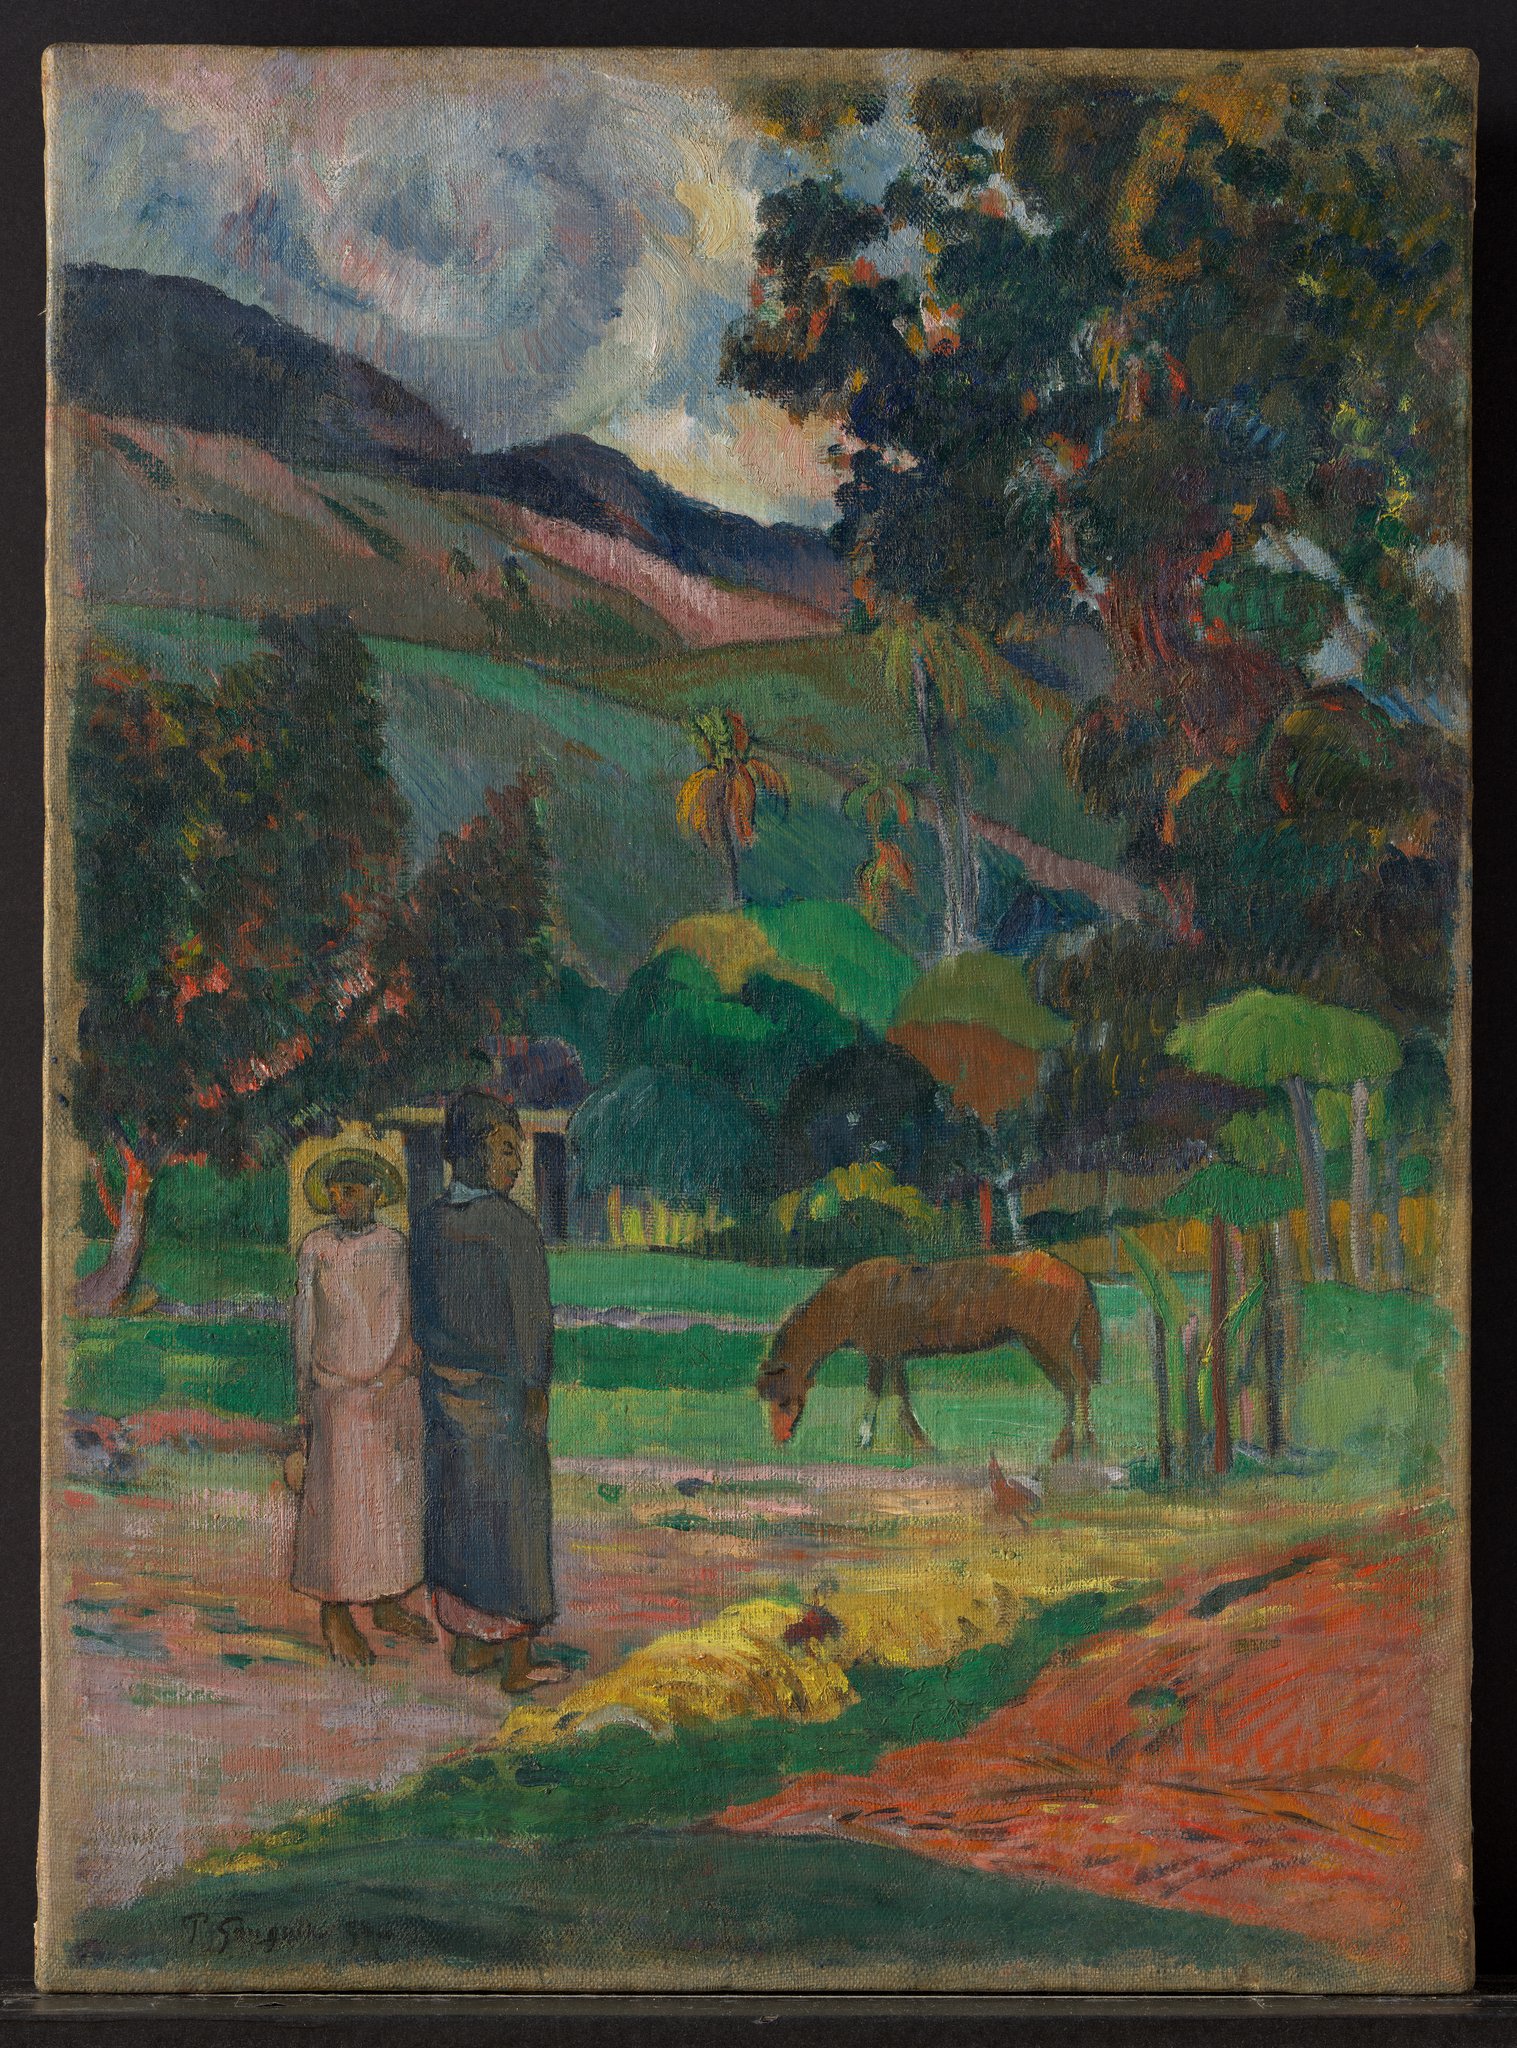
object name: painting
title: Tahitian Landscape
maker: paul gauguin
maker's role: artist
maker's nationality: french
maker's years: 1848-1903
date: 1892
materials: canvas, oil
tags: men,women,horses,landscapes